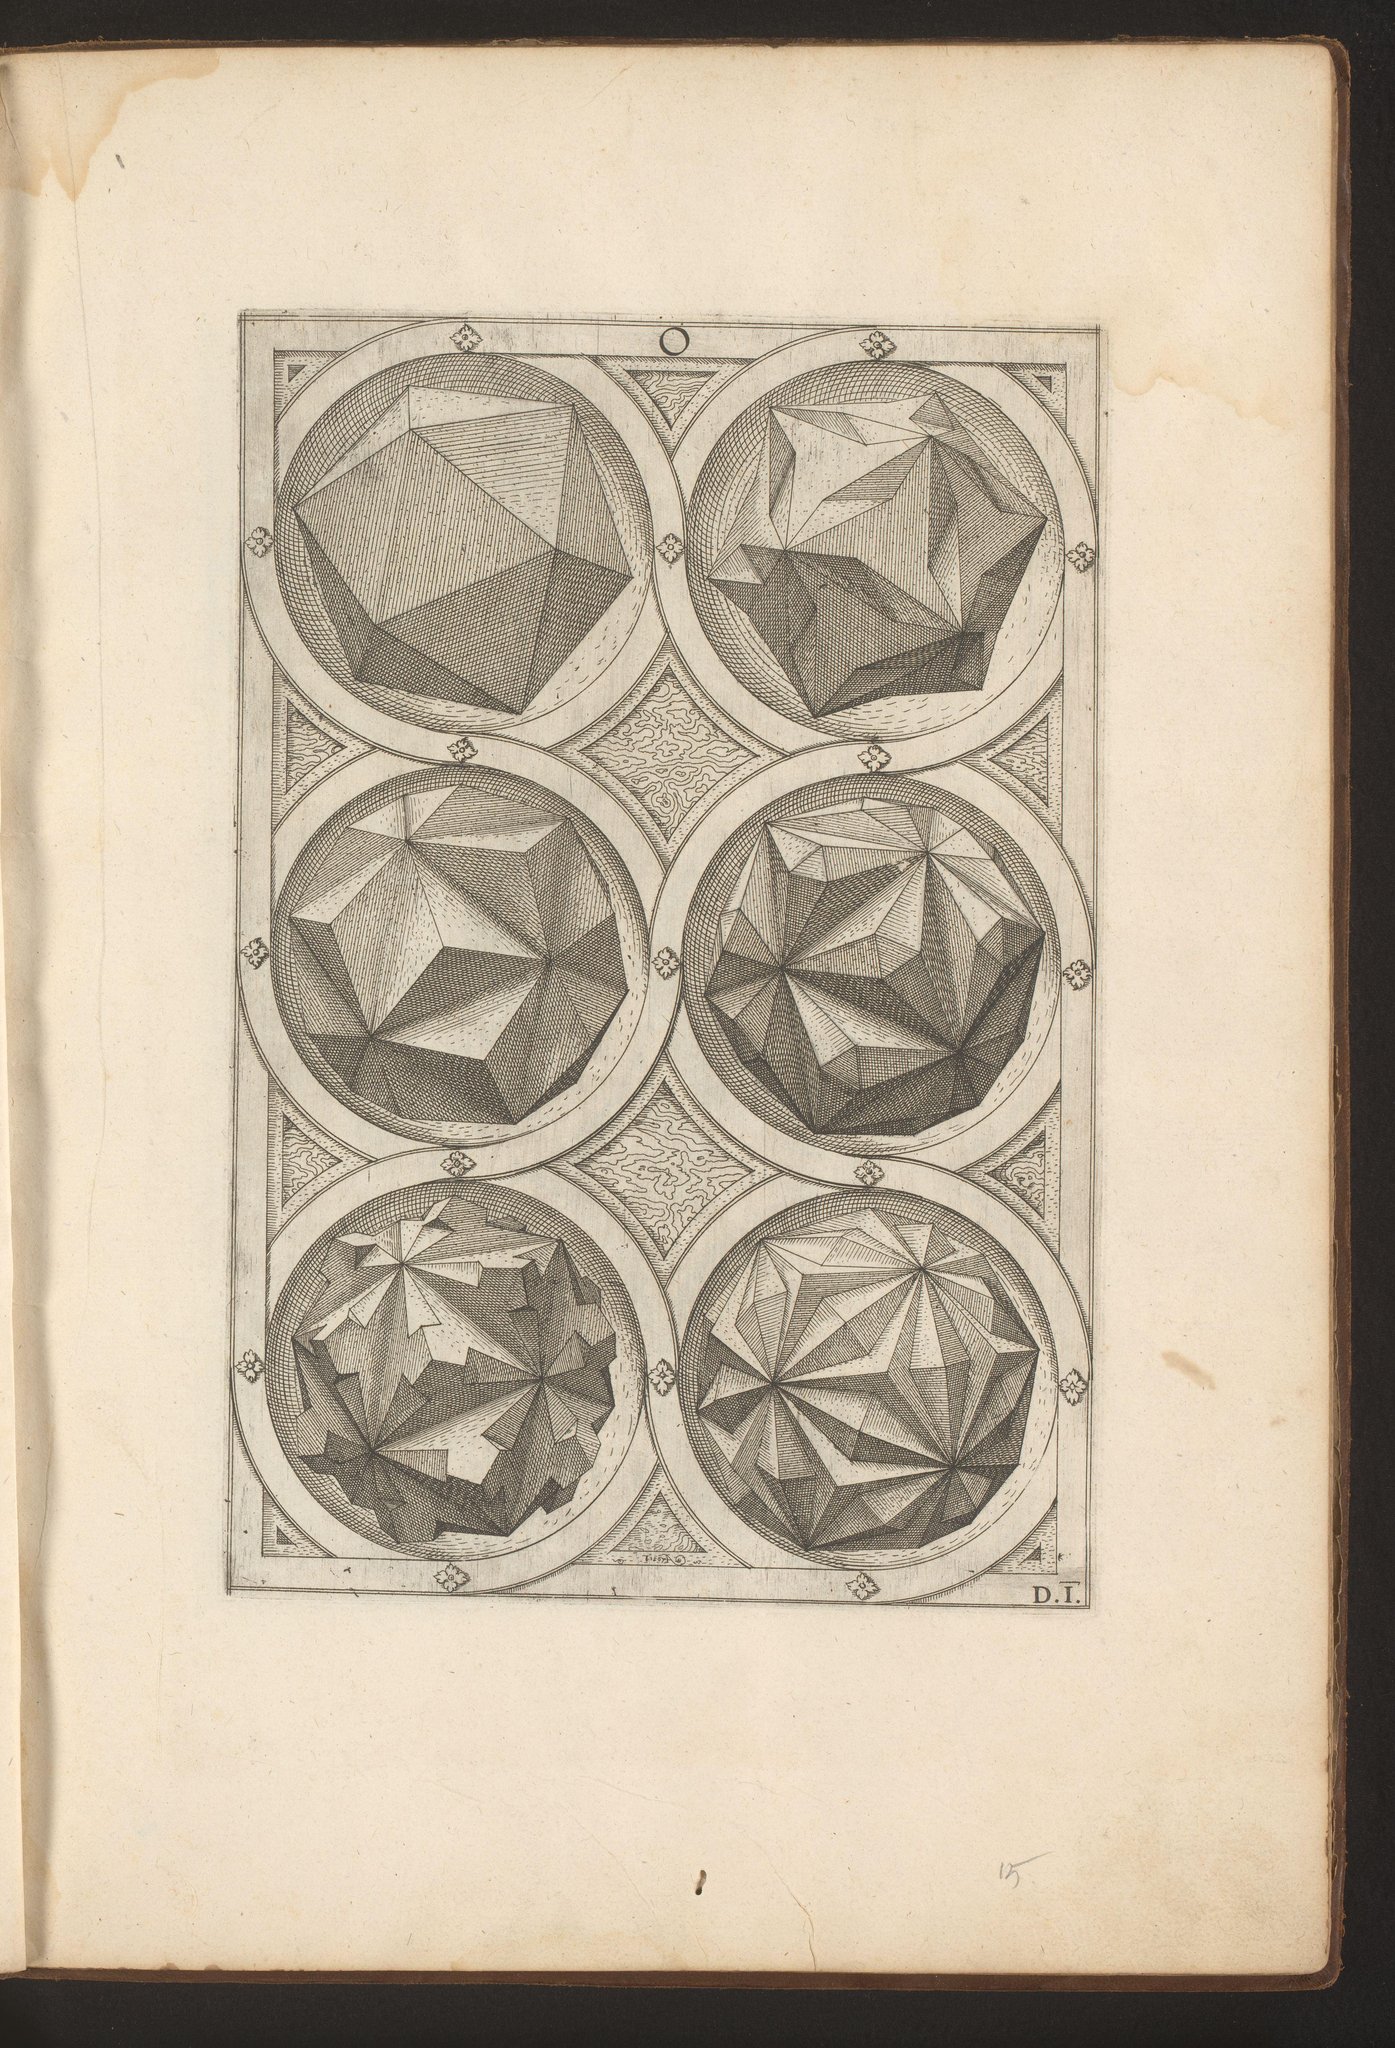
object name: page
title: Zes veelvlakken met een icosaëder als uitgangspunt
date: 1568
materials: paper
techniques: etching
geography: nuremberg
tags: other polyhedrons, icosahedron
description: De geometrische figuren (polyhedra) worden van boven naar beneden complexer. Rechtsonder genummerd: D.I. Deze prent maakt deel uit van een boek.